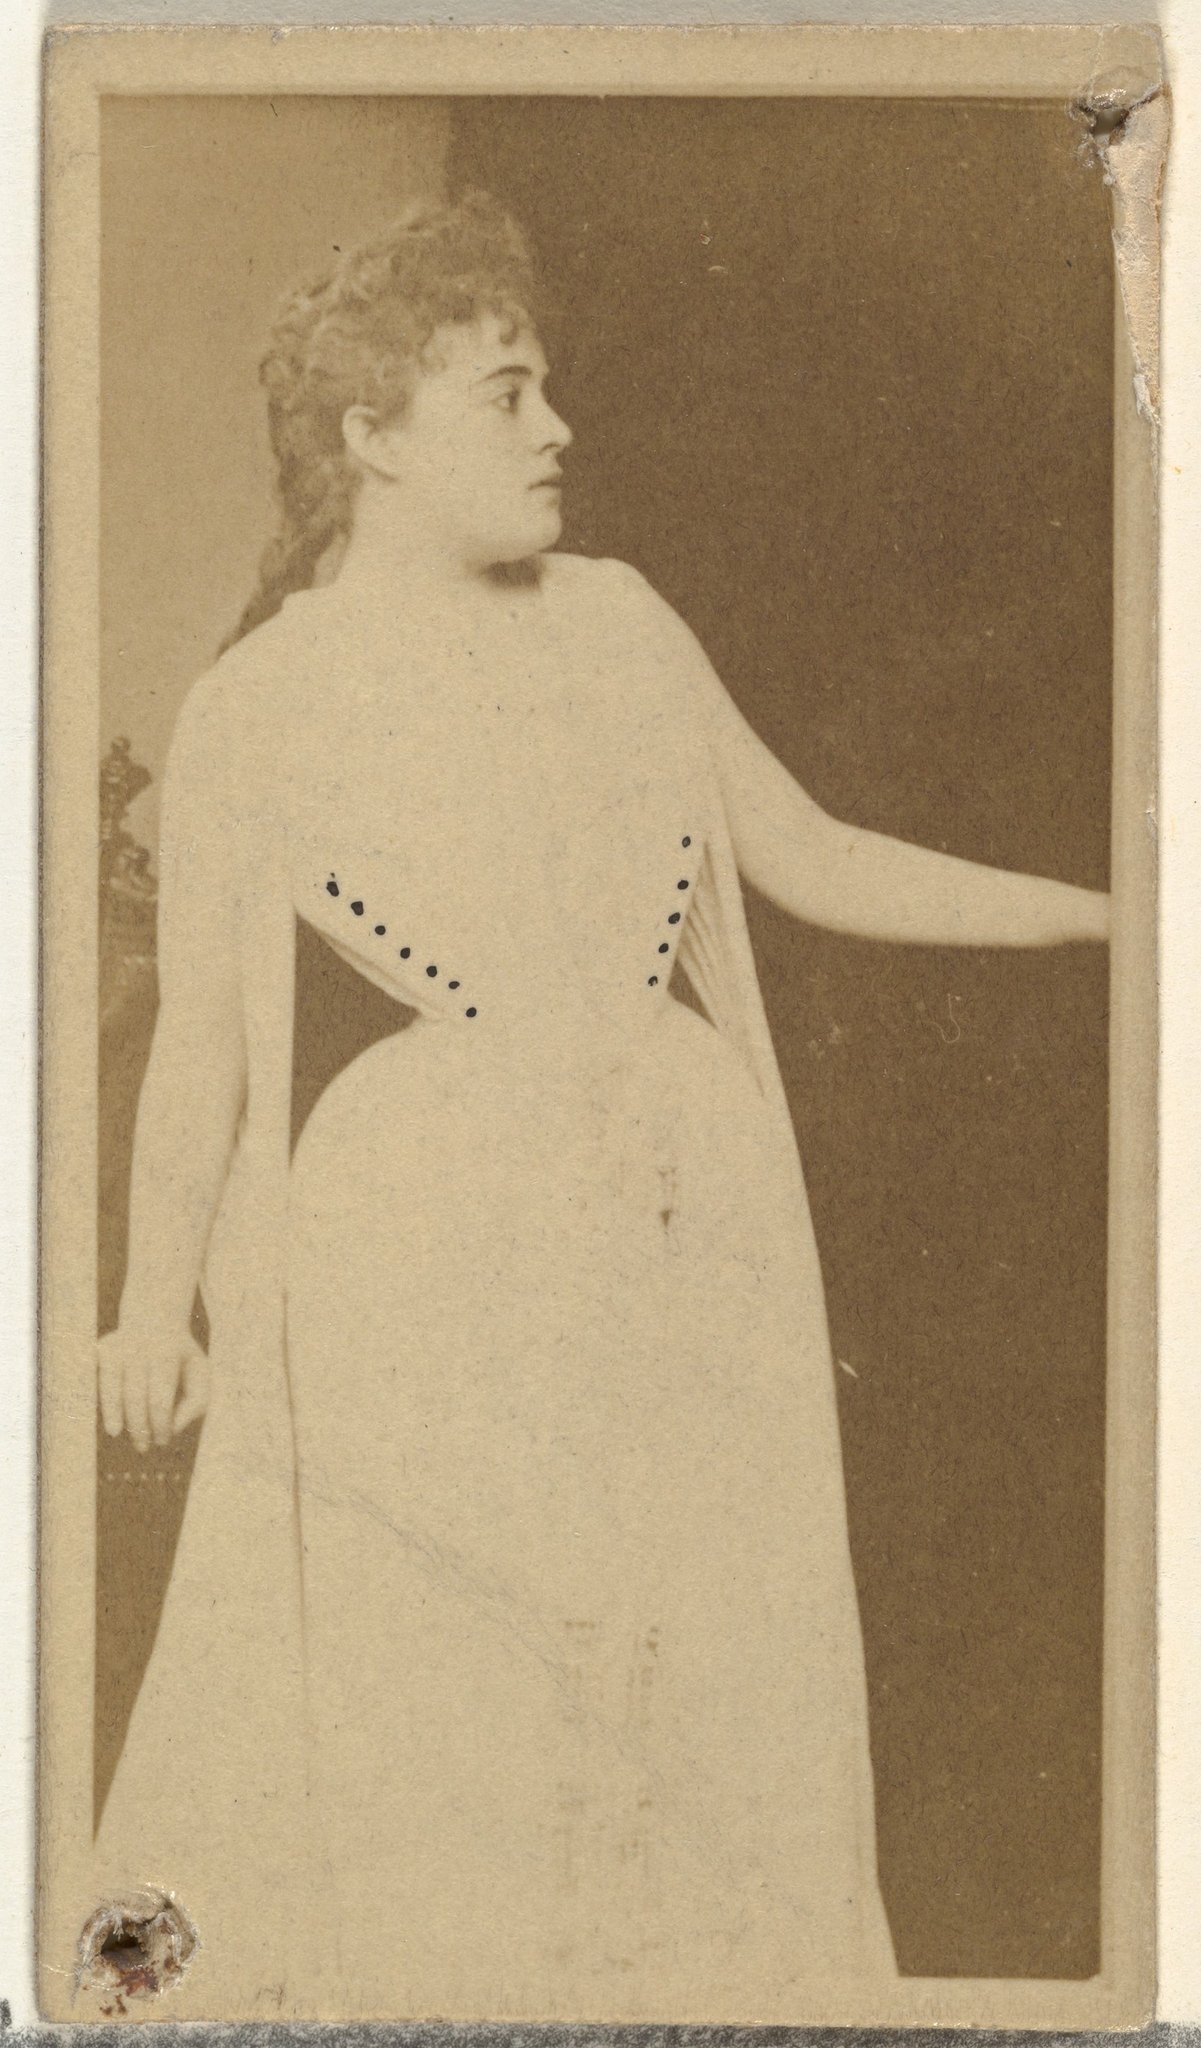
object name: photograph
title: [Actress standing in profile], from the Actors and Actresses series (N145-8) issued by Duke Sons & Co. to promote Duke Cigarettes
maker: w. duke, sons & co.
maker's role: publisher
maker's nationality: american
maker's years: 1870-1920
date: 1891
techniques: albumen silver print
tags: women,actresses